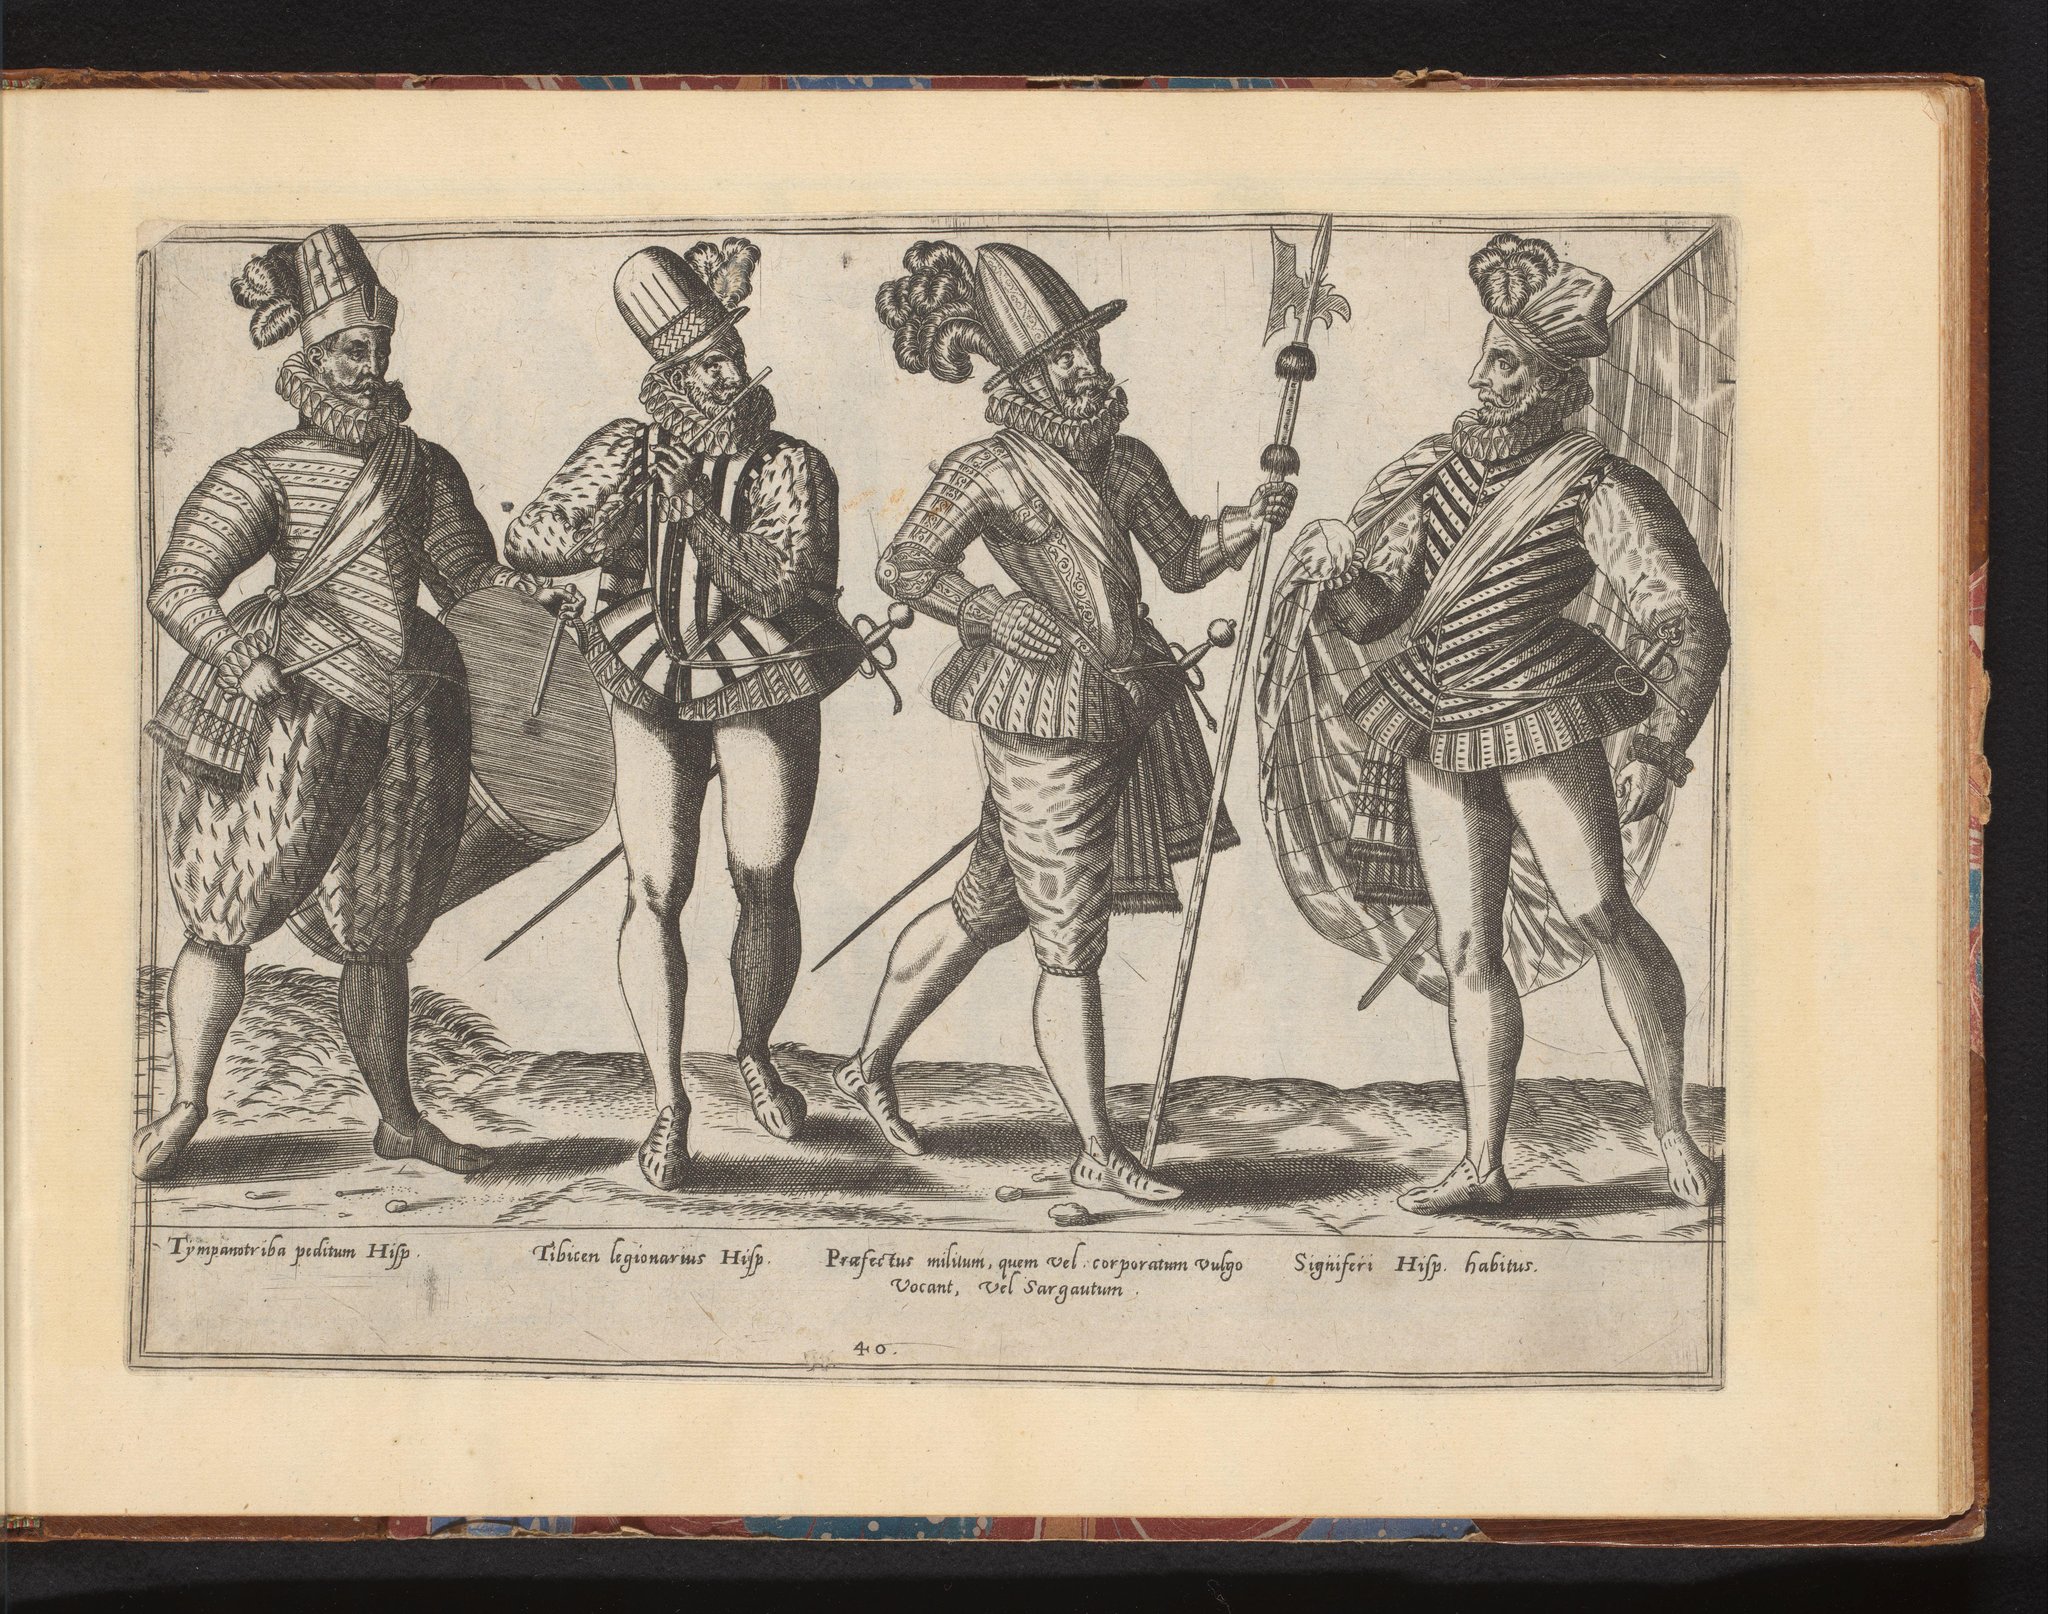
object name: album leaf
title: Vier Spaanse soldaten, gekleed volgens de mode van ca. 1580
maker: abraham de bruyn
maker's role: print maker, publisher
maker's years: 1540-1587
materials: paper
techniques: engraving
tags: europeans: spaniards (+ costume), europeans: spaniards (+ men), clothes, costume (+ men's clothes)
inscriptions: number: ‘40’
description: Prent uit het boek 'Omnium pene Europae, Asiae, Aphricae atque Americae gentium habitus...', 1581. De prent maakt deel uit van een album.